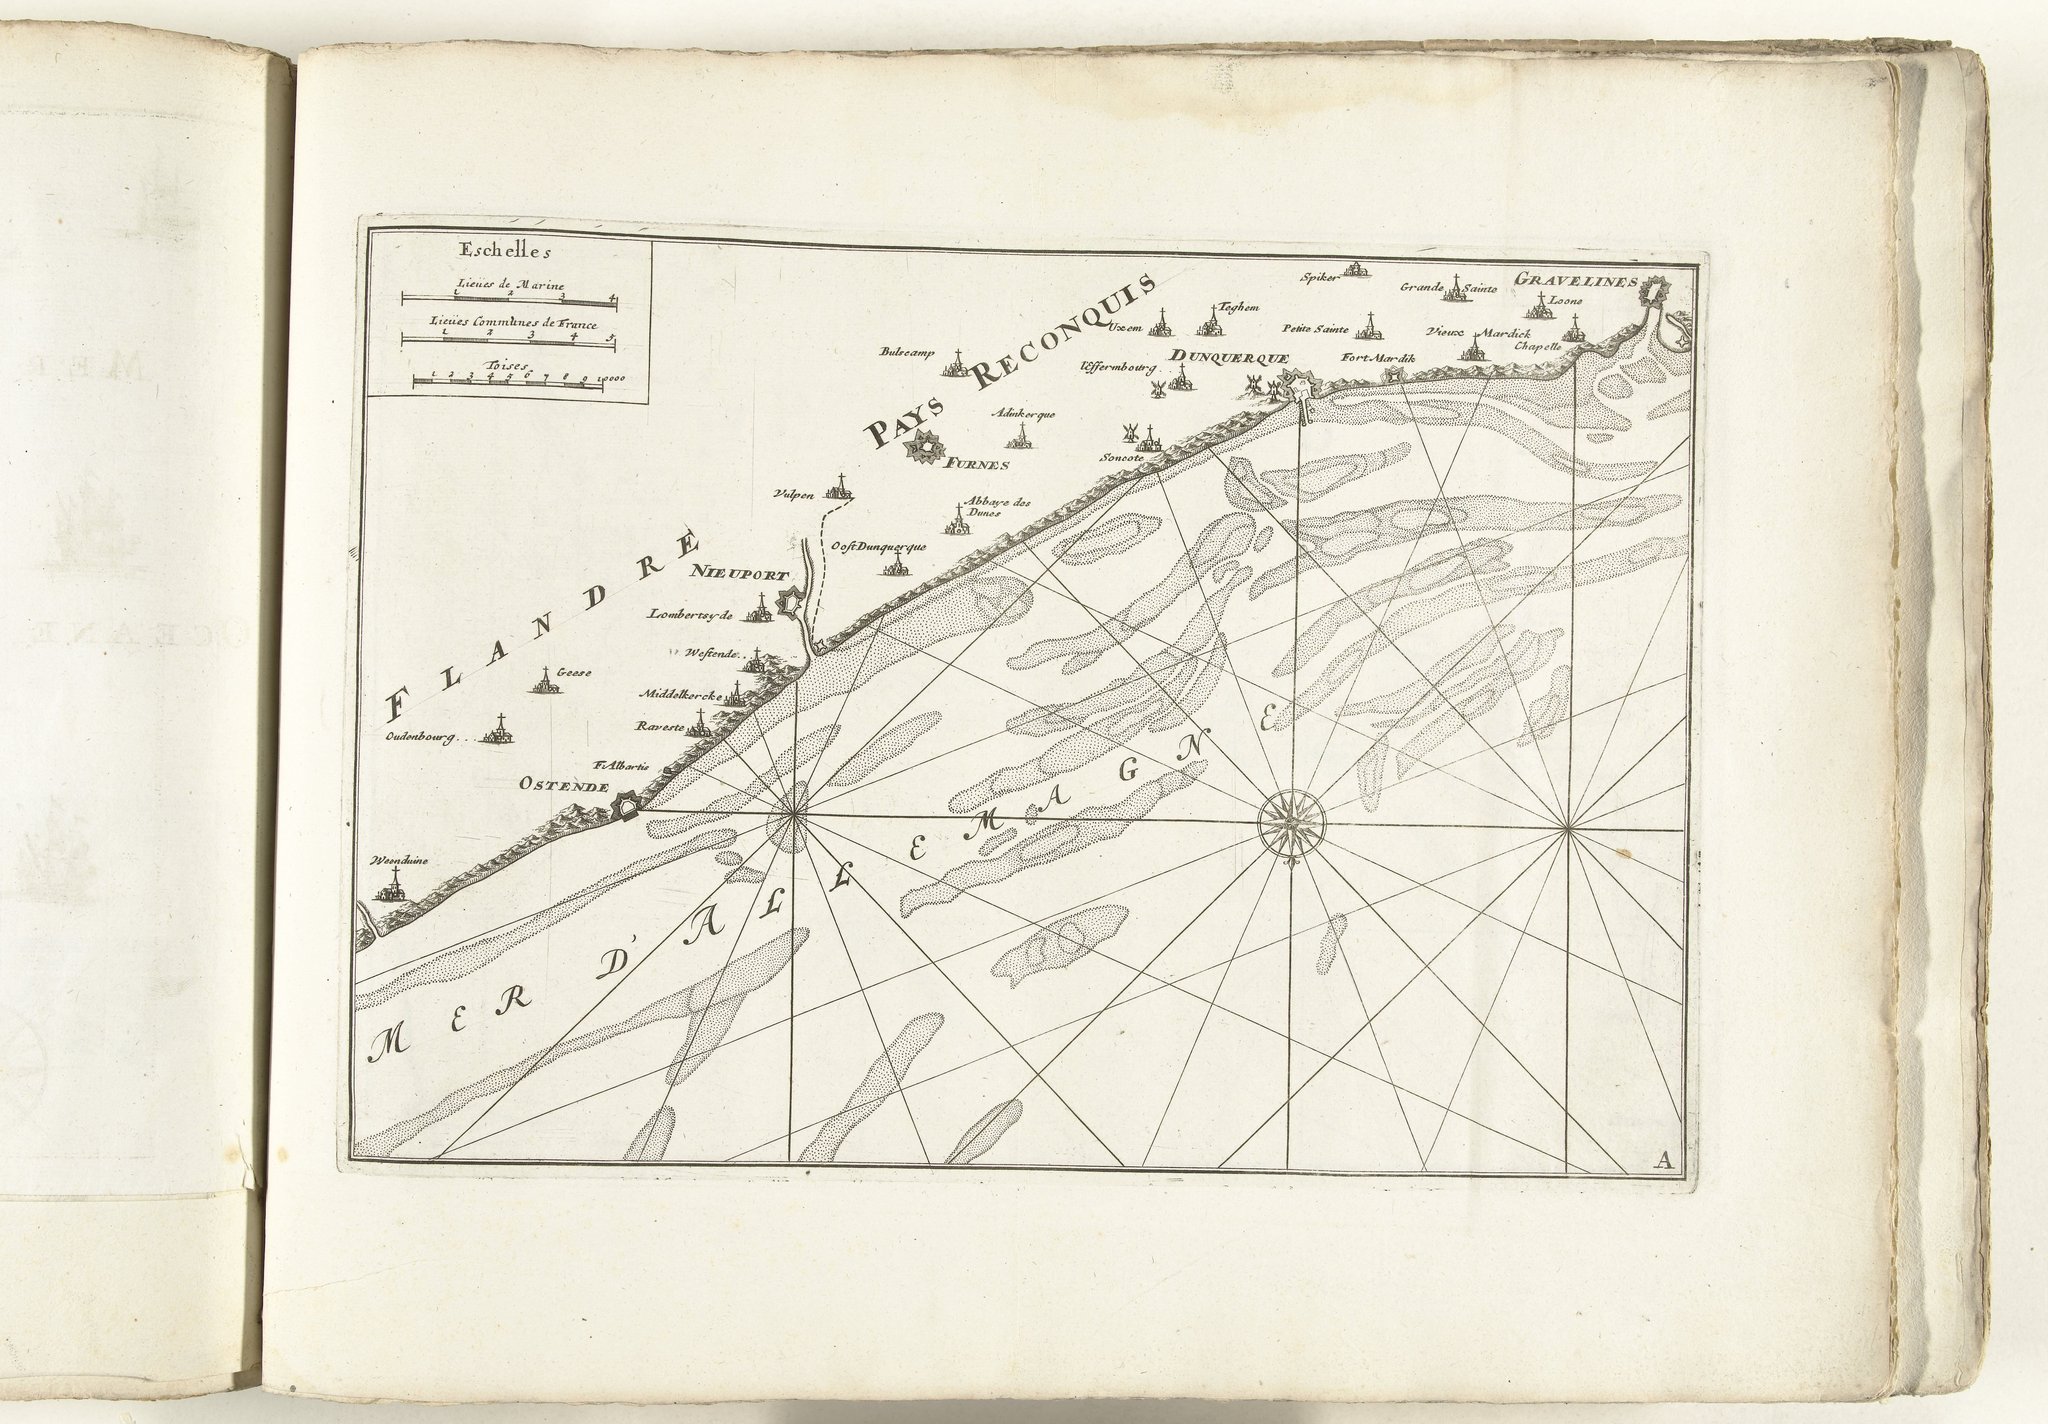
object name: map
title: Les Forces de l'Europe, Asie, Afrique et Amerique, ou description des principales villes avec leurs fortifications. Dessignées par les meilleurs ingenieurs, particulierement celles qui sont sous la domination de la France (...) et ornées de plusieurs superbes edifices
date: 1702-1703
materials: paper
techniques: etching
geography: amsterdam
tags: maps of separate countries or regions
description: Kaart van de Vlaamse kust tussen Gravelines en Oostende. Gemerkt rechtsonder: A. Onderdeel van het eerste van twee delen van het prentwerk: Les costes de France et d'Espagne (oftewel deel 13 van: Les Forces de l'Europe, Asie, Afrique et Amerique), uitgegeven ca. 1702. Het prentwerk bestaat in totaal uit 43 gemerkte platen van de kust van Frankrijk en Spanje, in het kader van de Spaanse Successieoorlog. Deze platen zijn gekopieerd naar anonieme Franse platen oorspronkelijk uitgegeven door Nicolas de Fer te Parijs. Titel en opschriften in de plaat in het Frans.